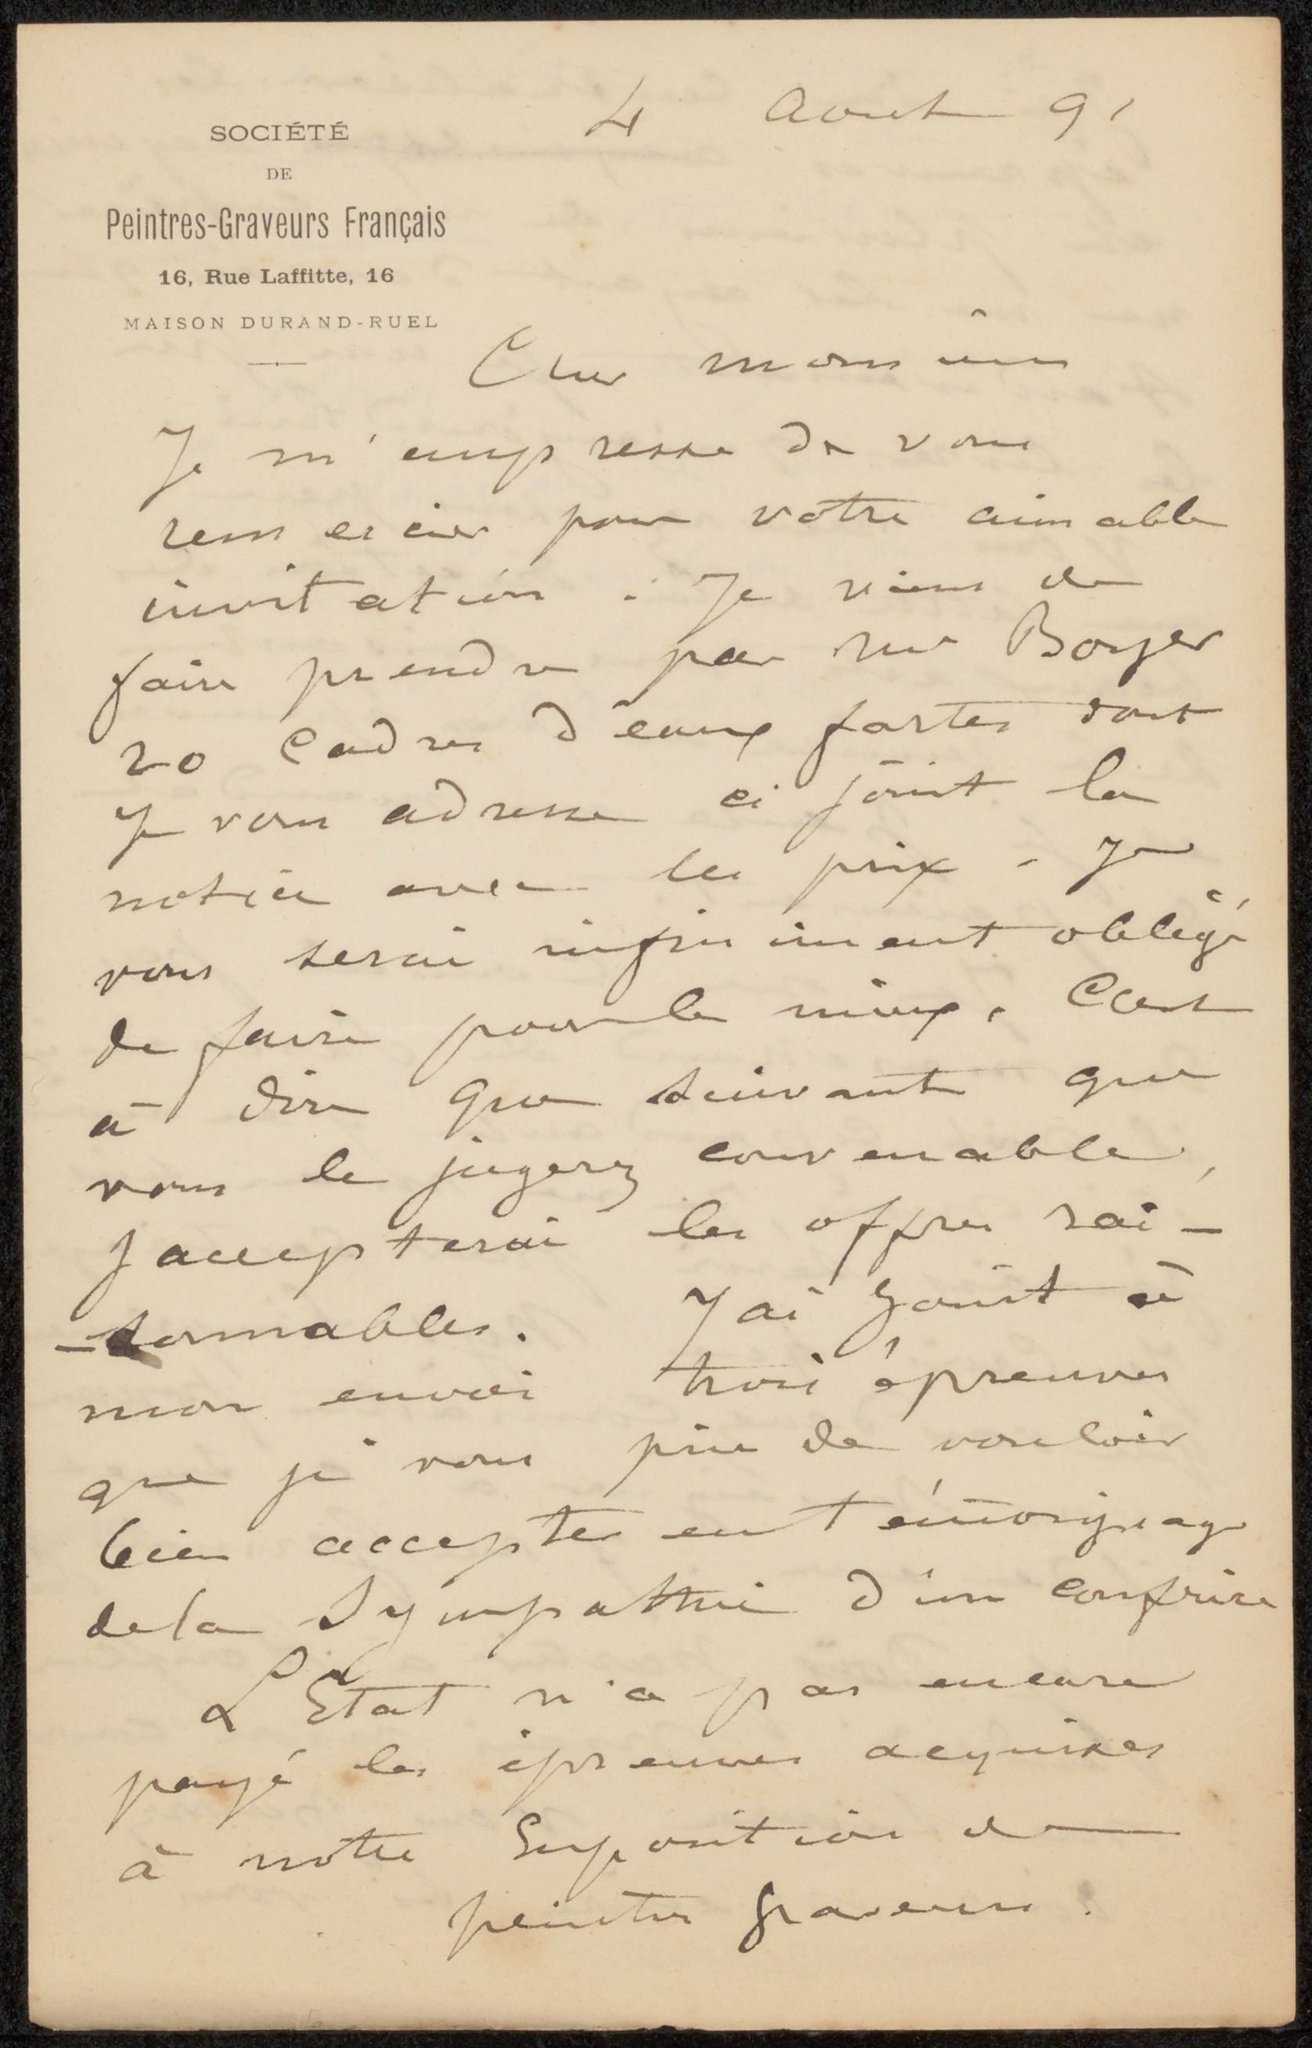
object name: letter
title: Brief aan Philip Zilcken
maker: henri charles guérard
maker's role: print maker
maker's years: 1846-1897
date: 1891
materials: ink, paper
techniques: pen, printing, writing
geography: paris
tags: the hague, draughtsman, philip zilcken, the graphic arts, exhibition ~ art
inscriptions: collector's mark: ‘RPK’